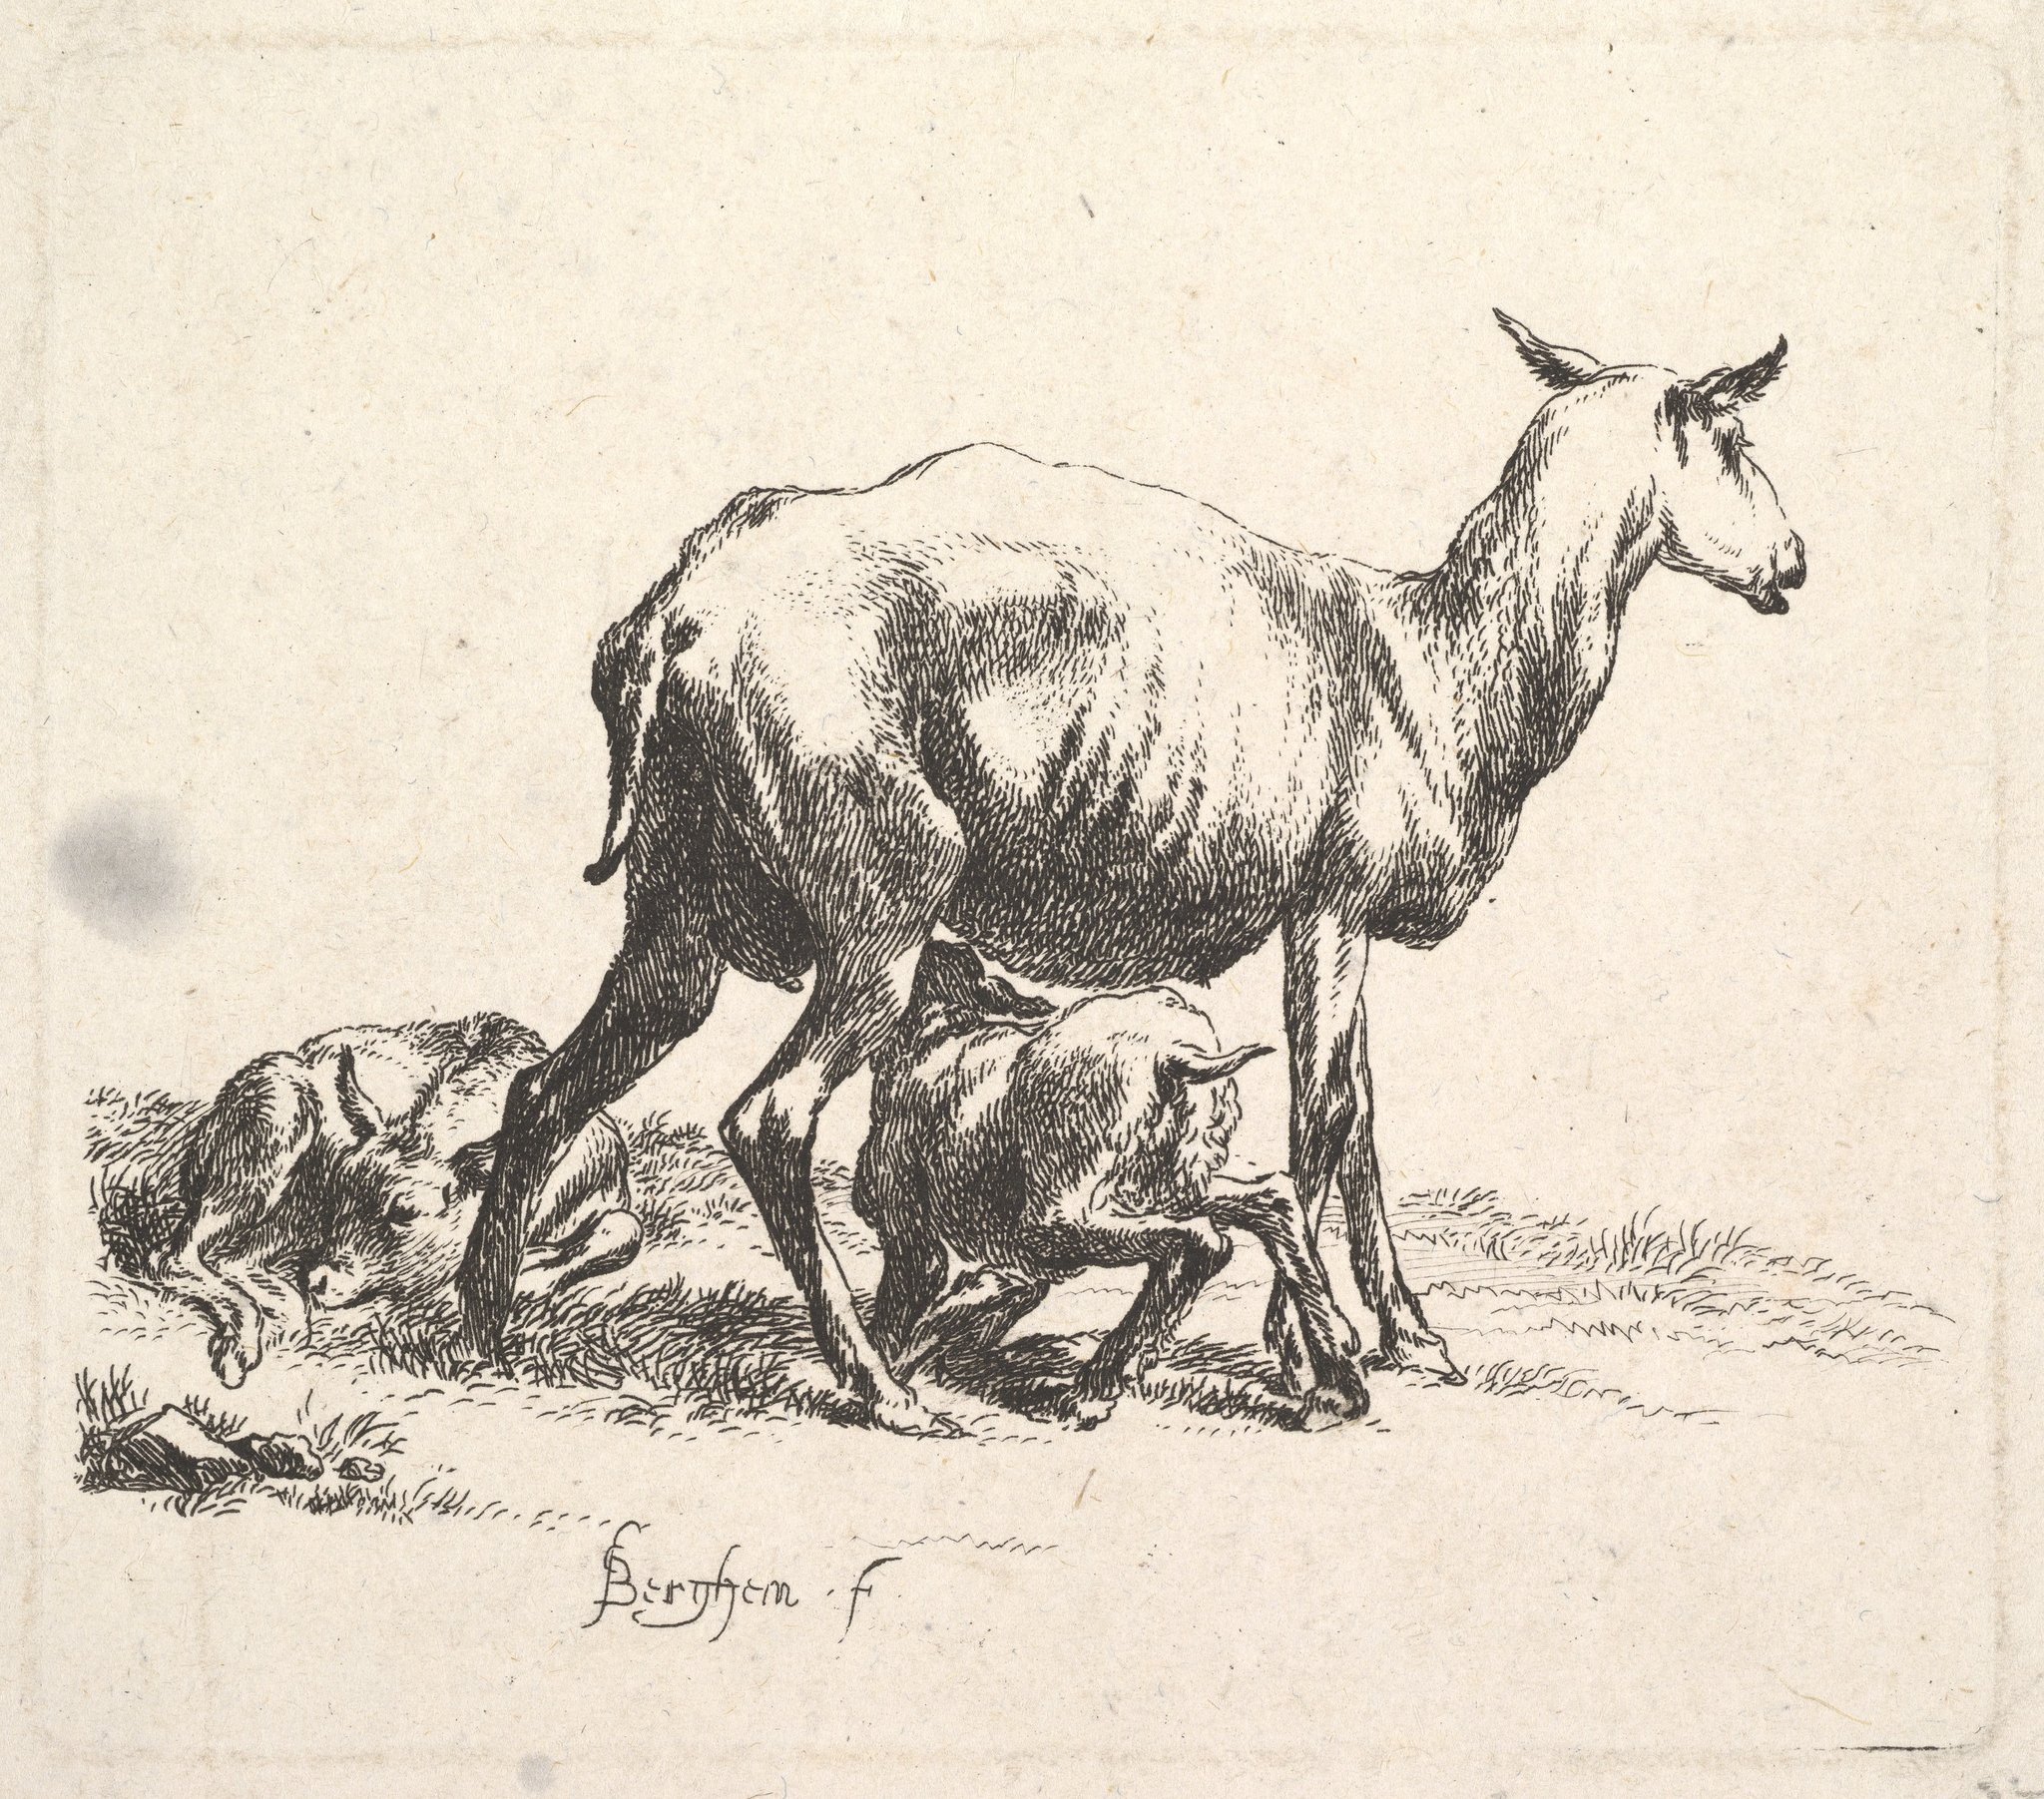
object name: print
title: Sheep with Lamb Nursing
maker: nicolaes pietersz berchem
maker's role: artist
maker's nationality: dutch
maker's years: 1620-1683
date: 1635-1683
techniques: etching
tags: lambs,sheep